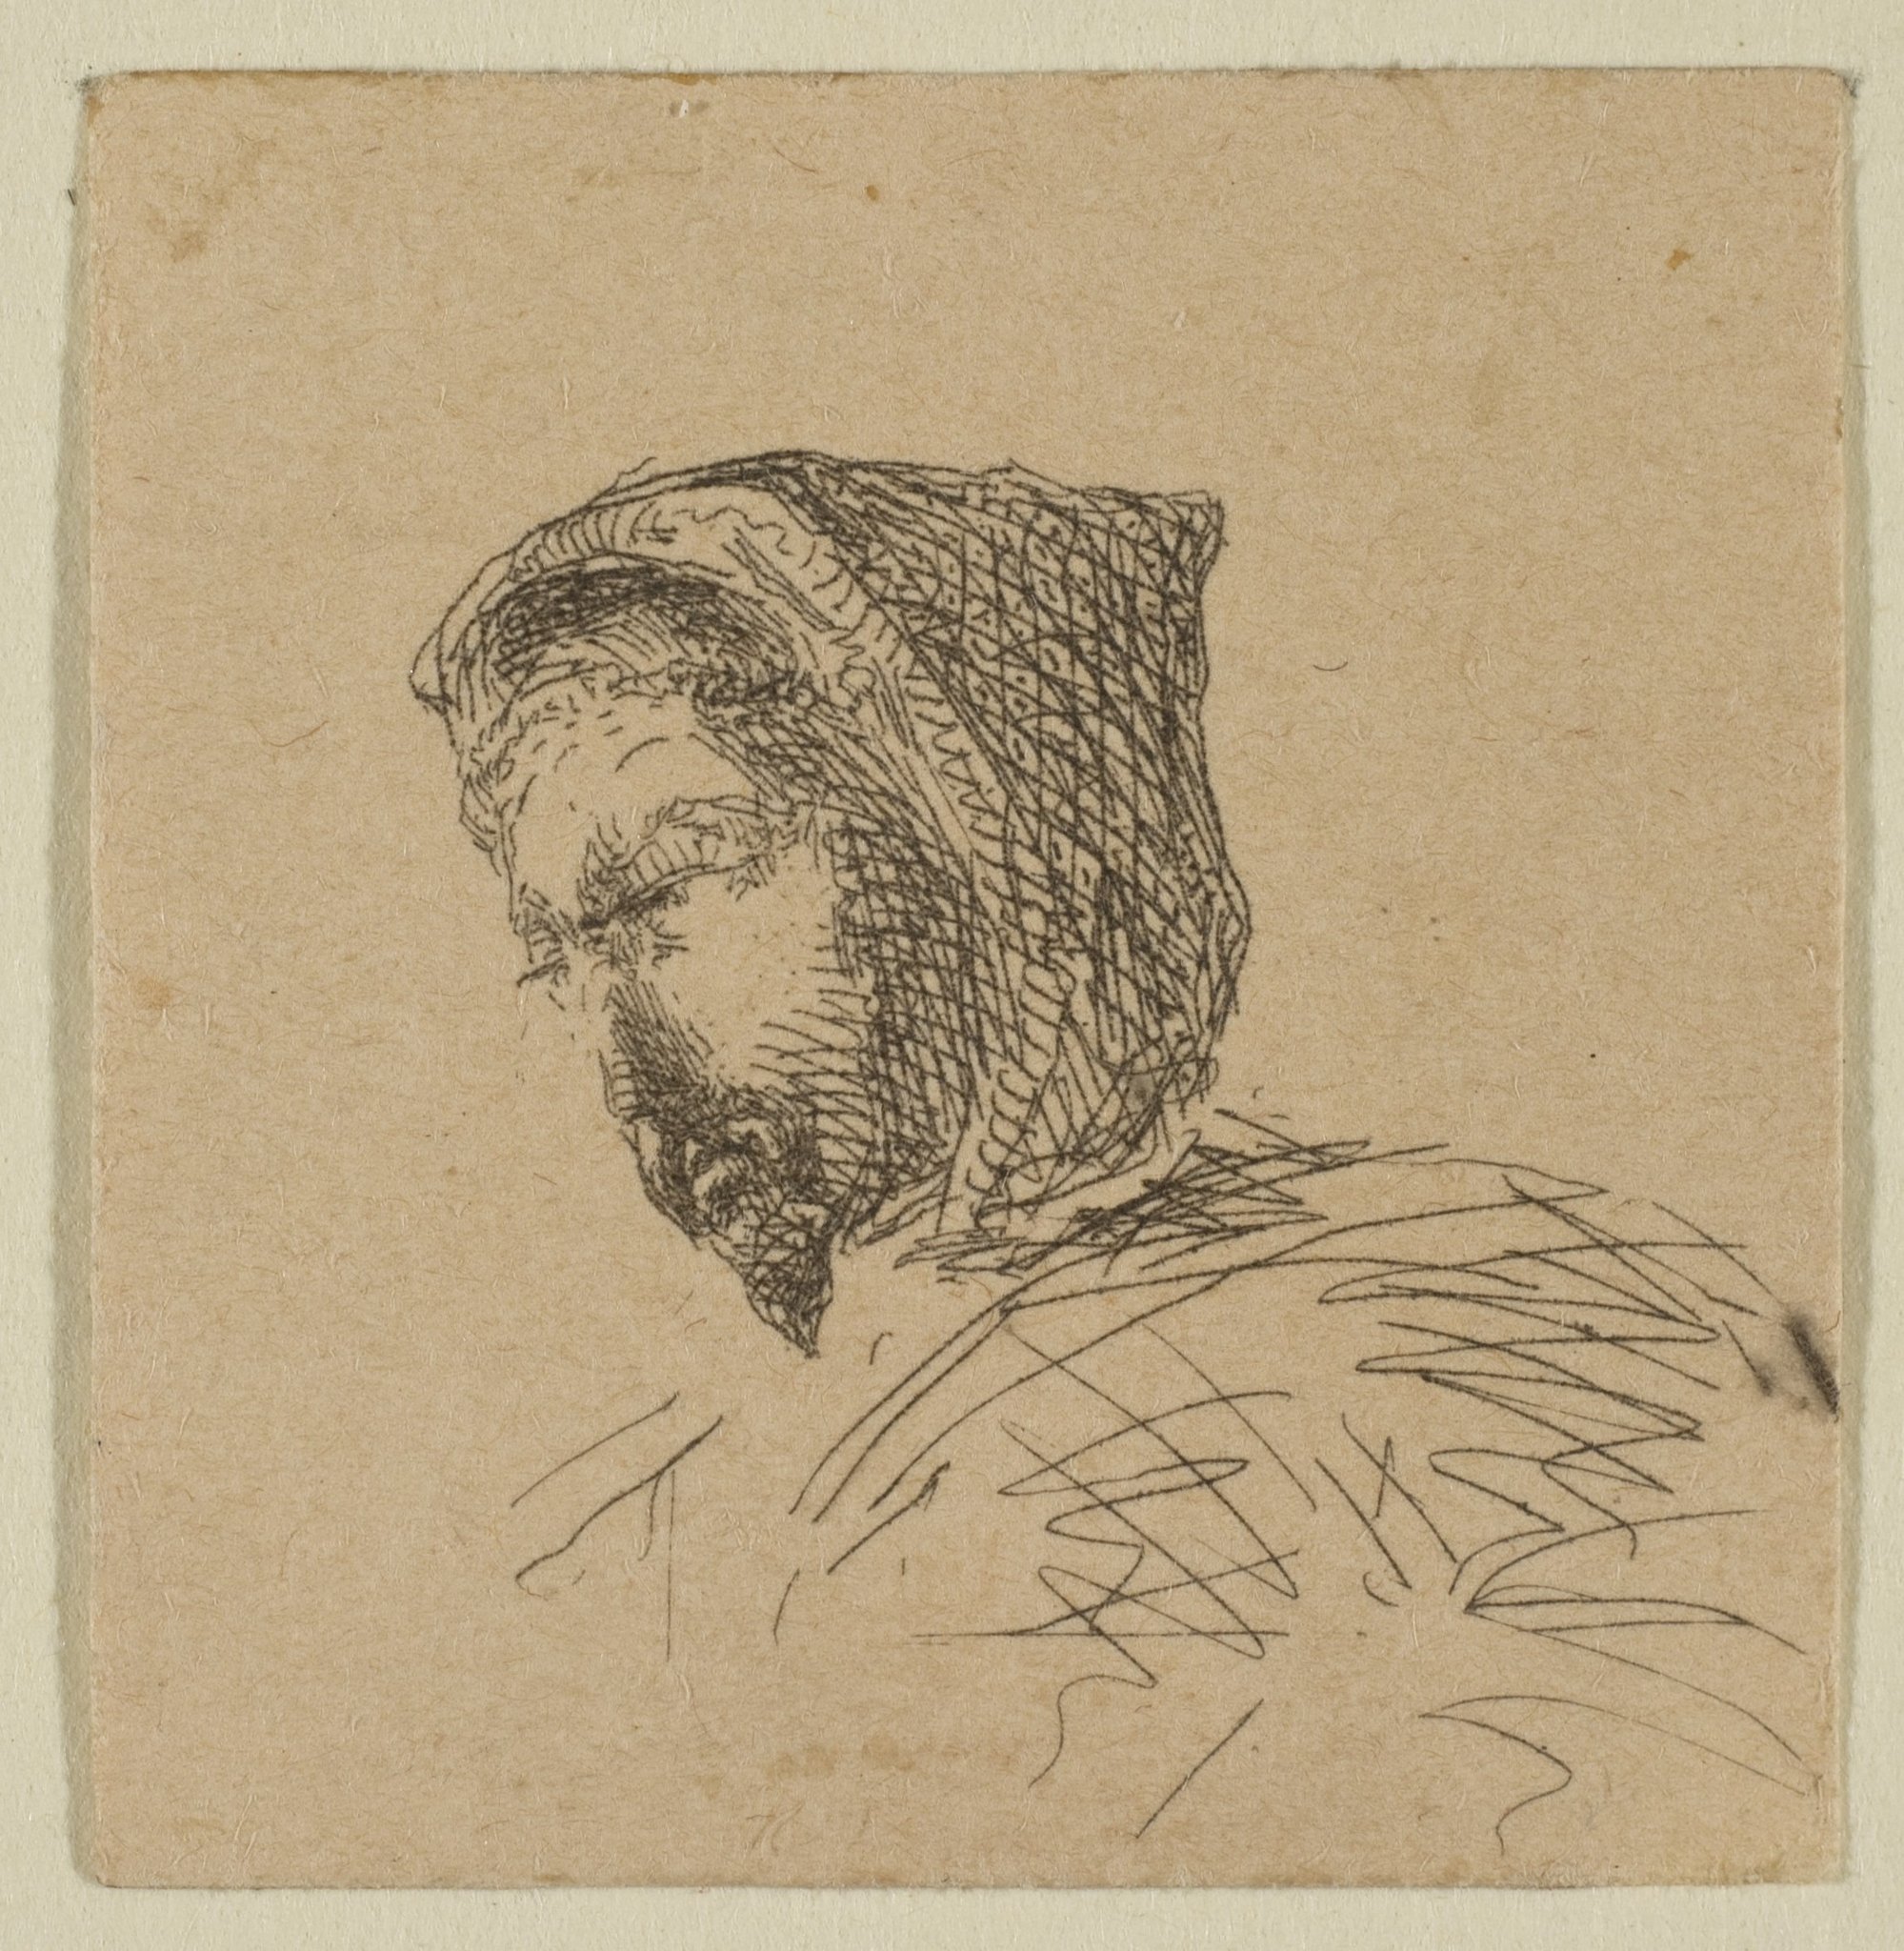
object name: print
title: Hooded Male Head (from Sketches on The Coast Survey Plate)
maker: james mcneill whistler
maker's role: artist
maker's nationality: american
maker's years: 1834-1903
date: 1854-1855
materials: board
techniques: cutting, etching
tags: heads,men